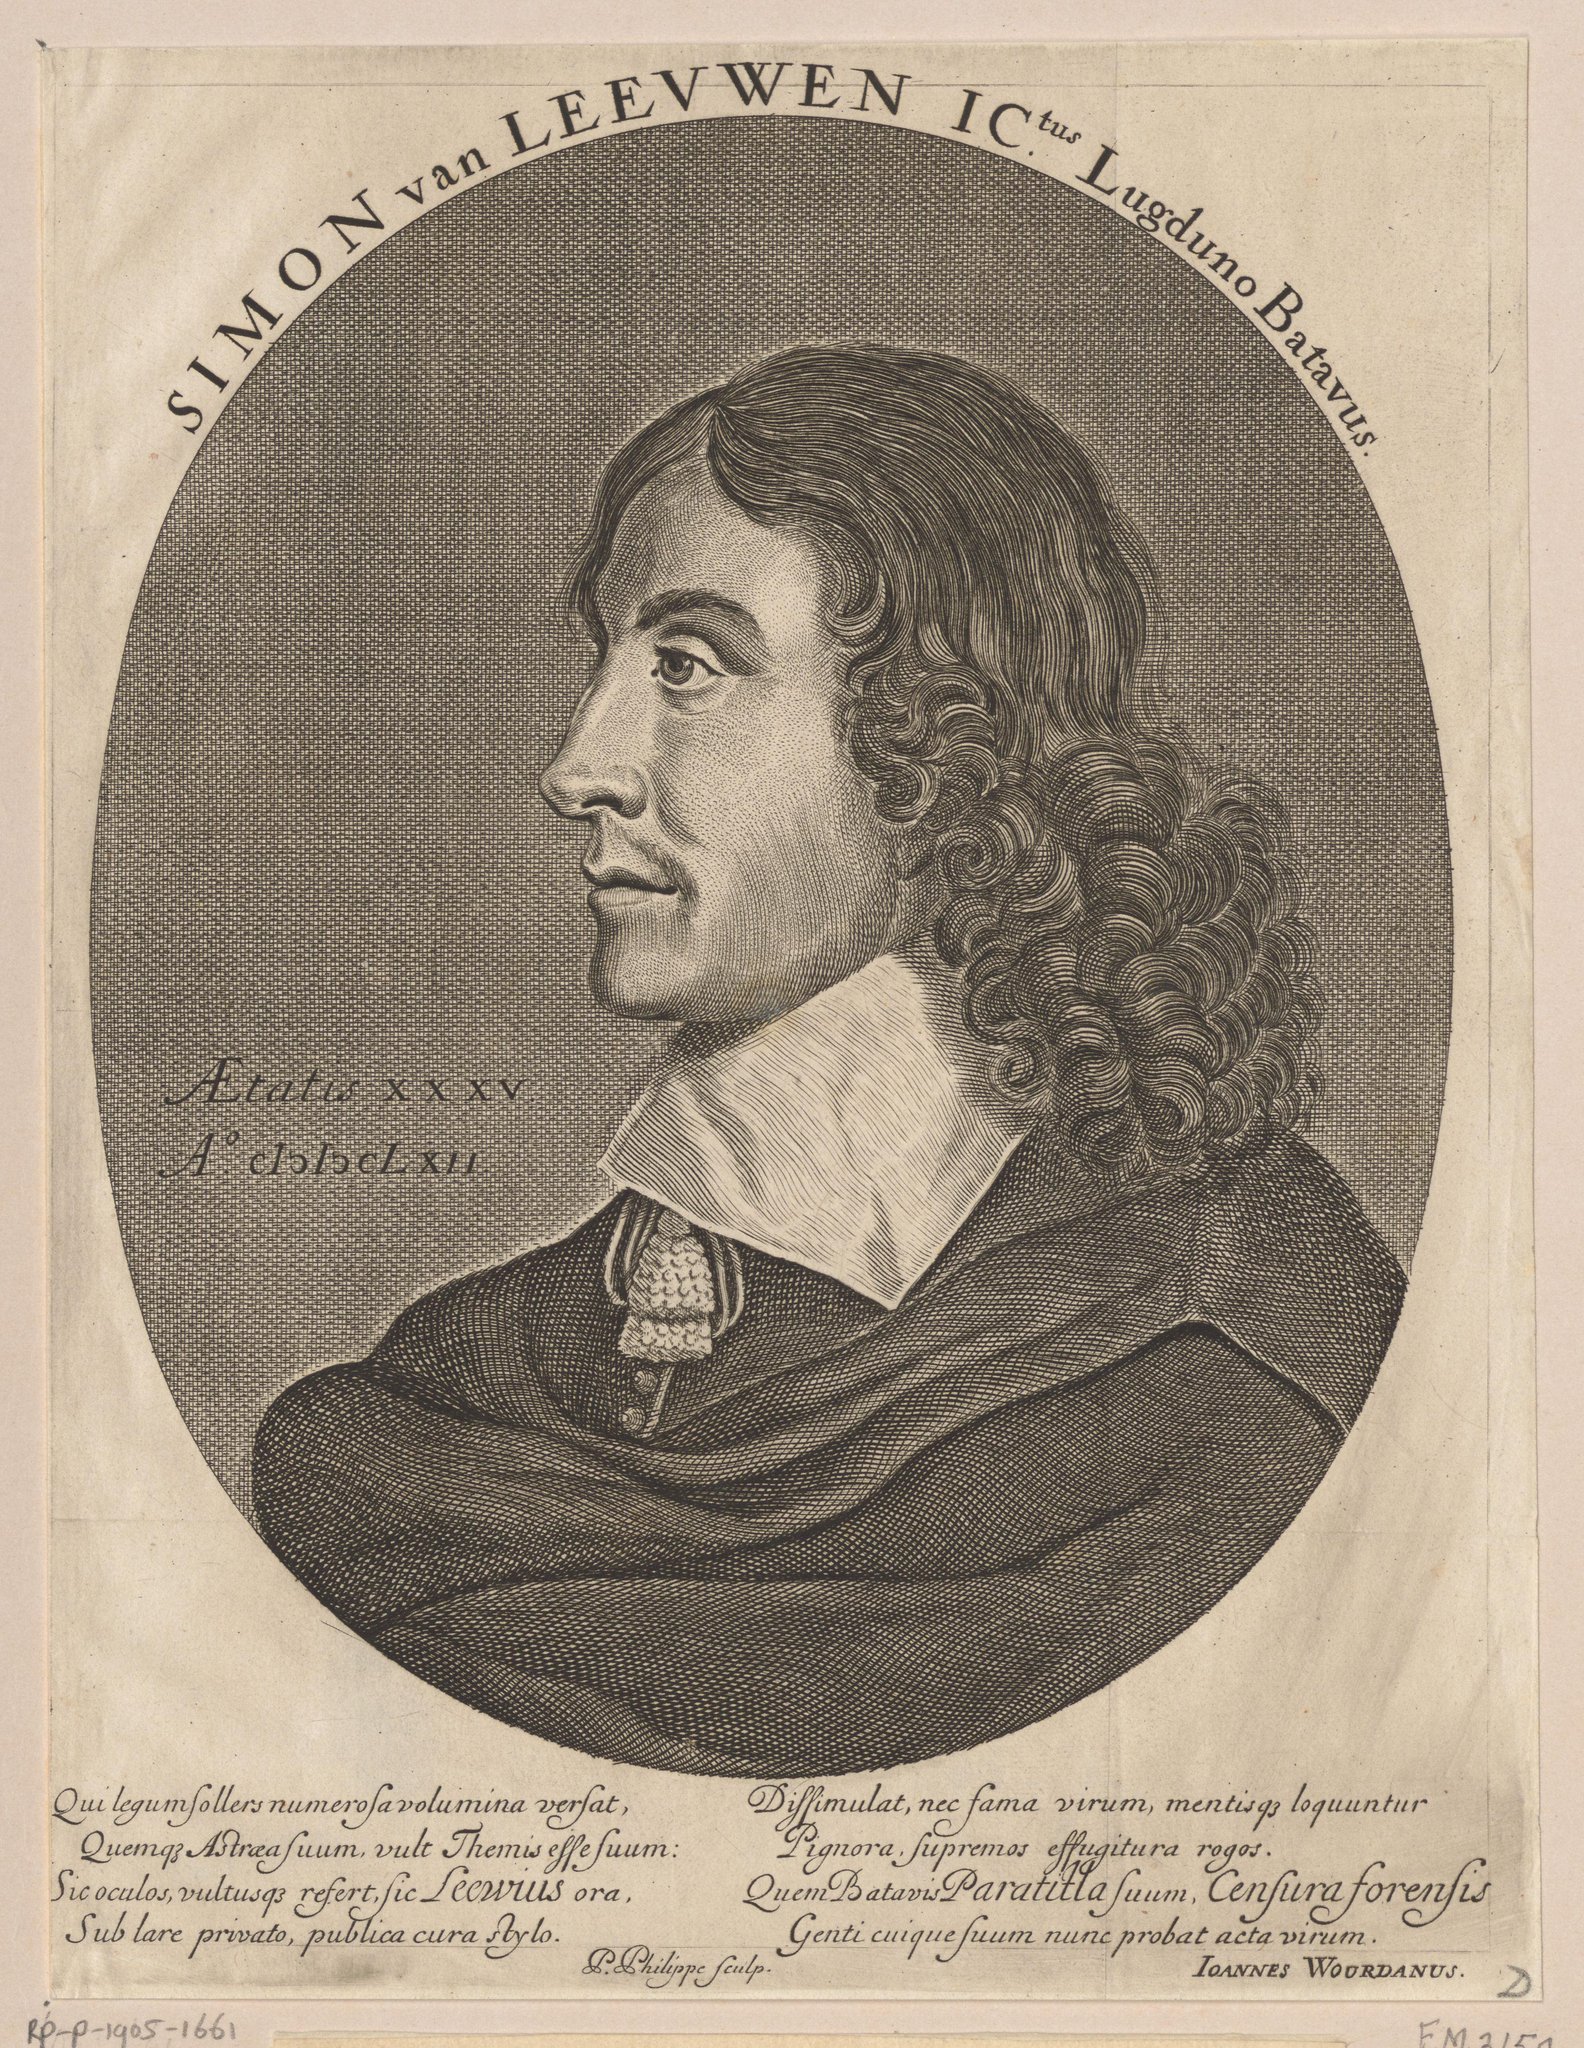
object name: print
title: Portret van Simon van Leeuwen op 35-jarige leeftijd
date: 1662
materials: paper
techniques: engraving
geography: the hague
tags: leiden, simon van leeuwen, historical persons, lawyer, attorney at law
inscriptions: collector's mark: Lugt 2228